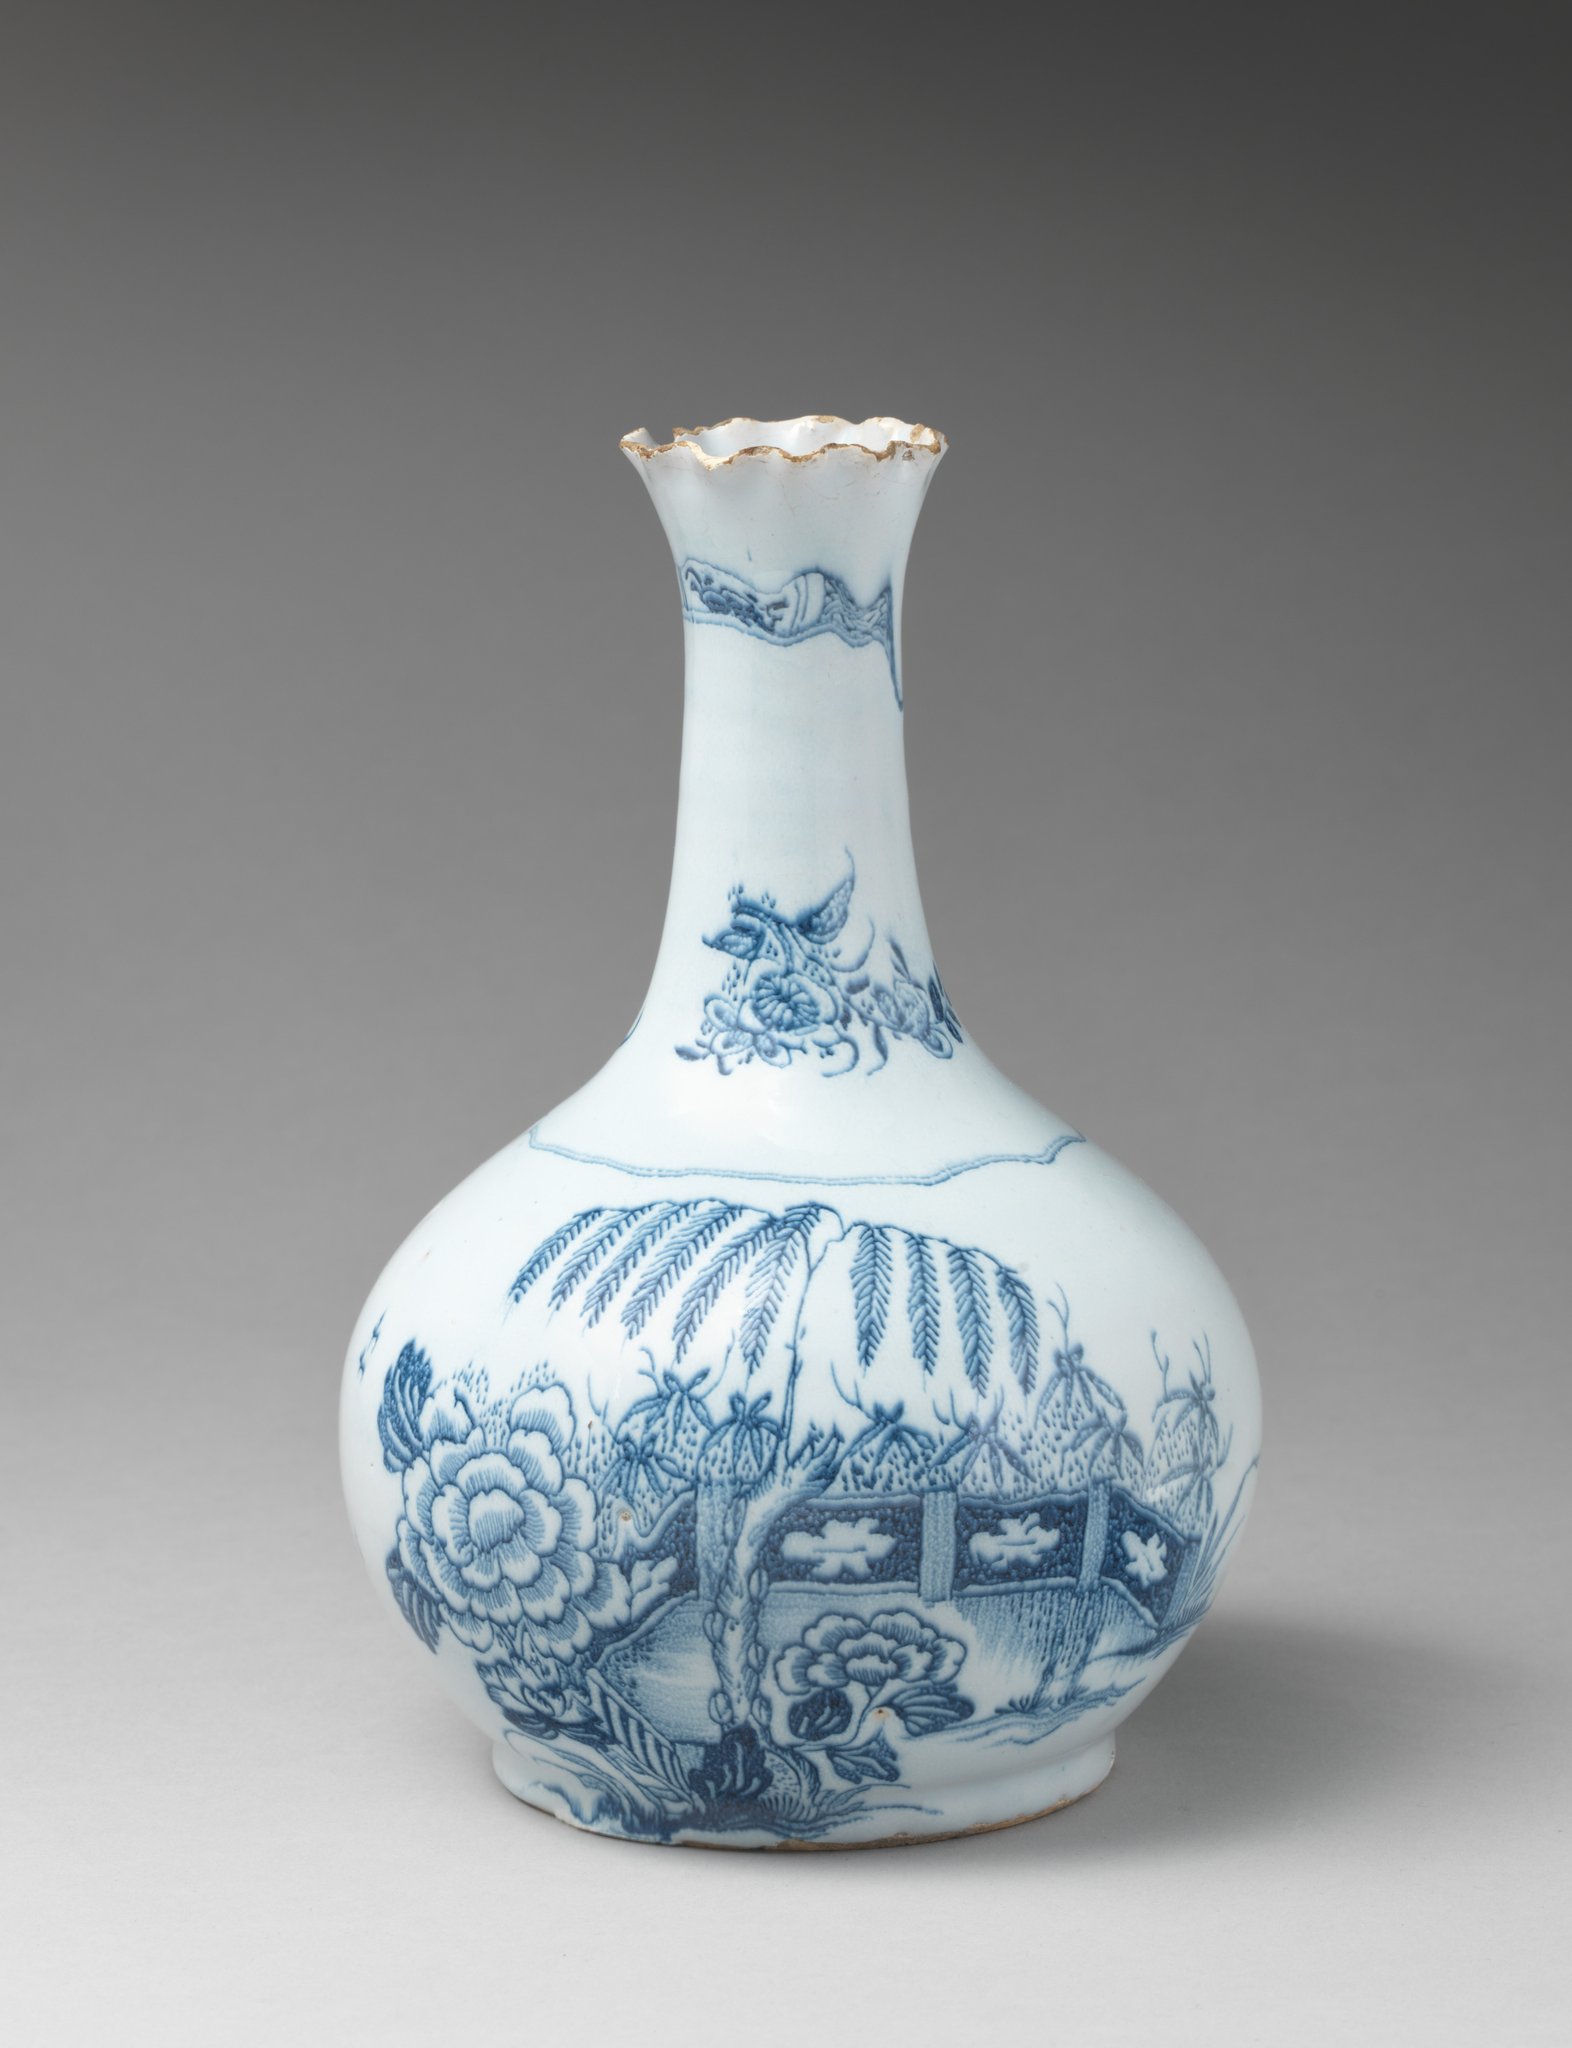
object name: wine bottle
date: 1750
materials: earthenware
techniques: glazing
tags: flowers,trees